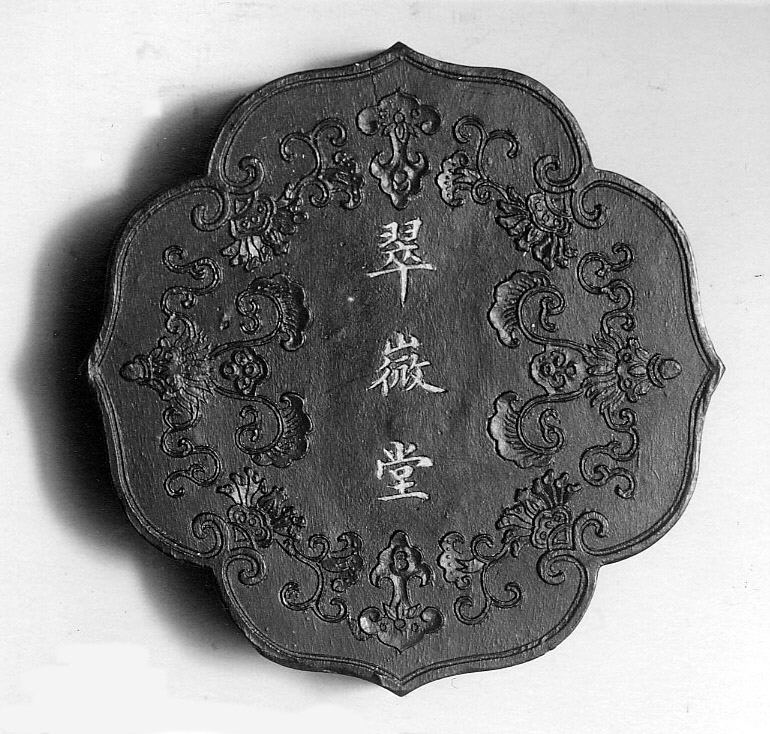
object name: ink tablet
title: The Green and Remote (Small)? Hall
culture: chinese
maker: jian guzhai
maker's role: artist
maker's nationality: chinese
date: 1867-1933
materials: ink